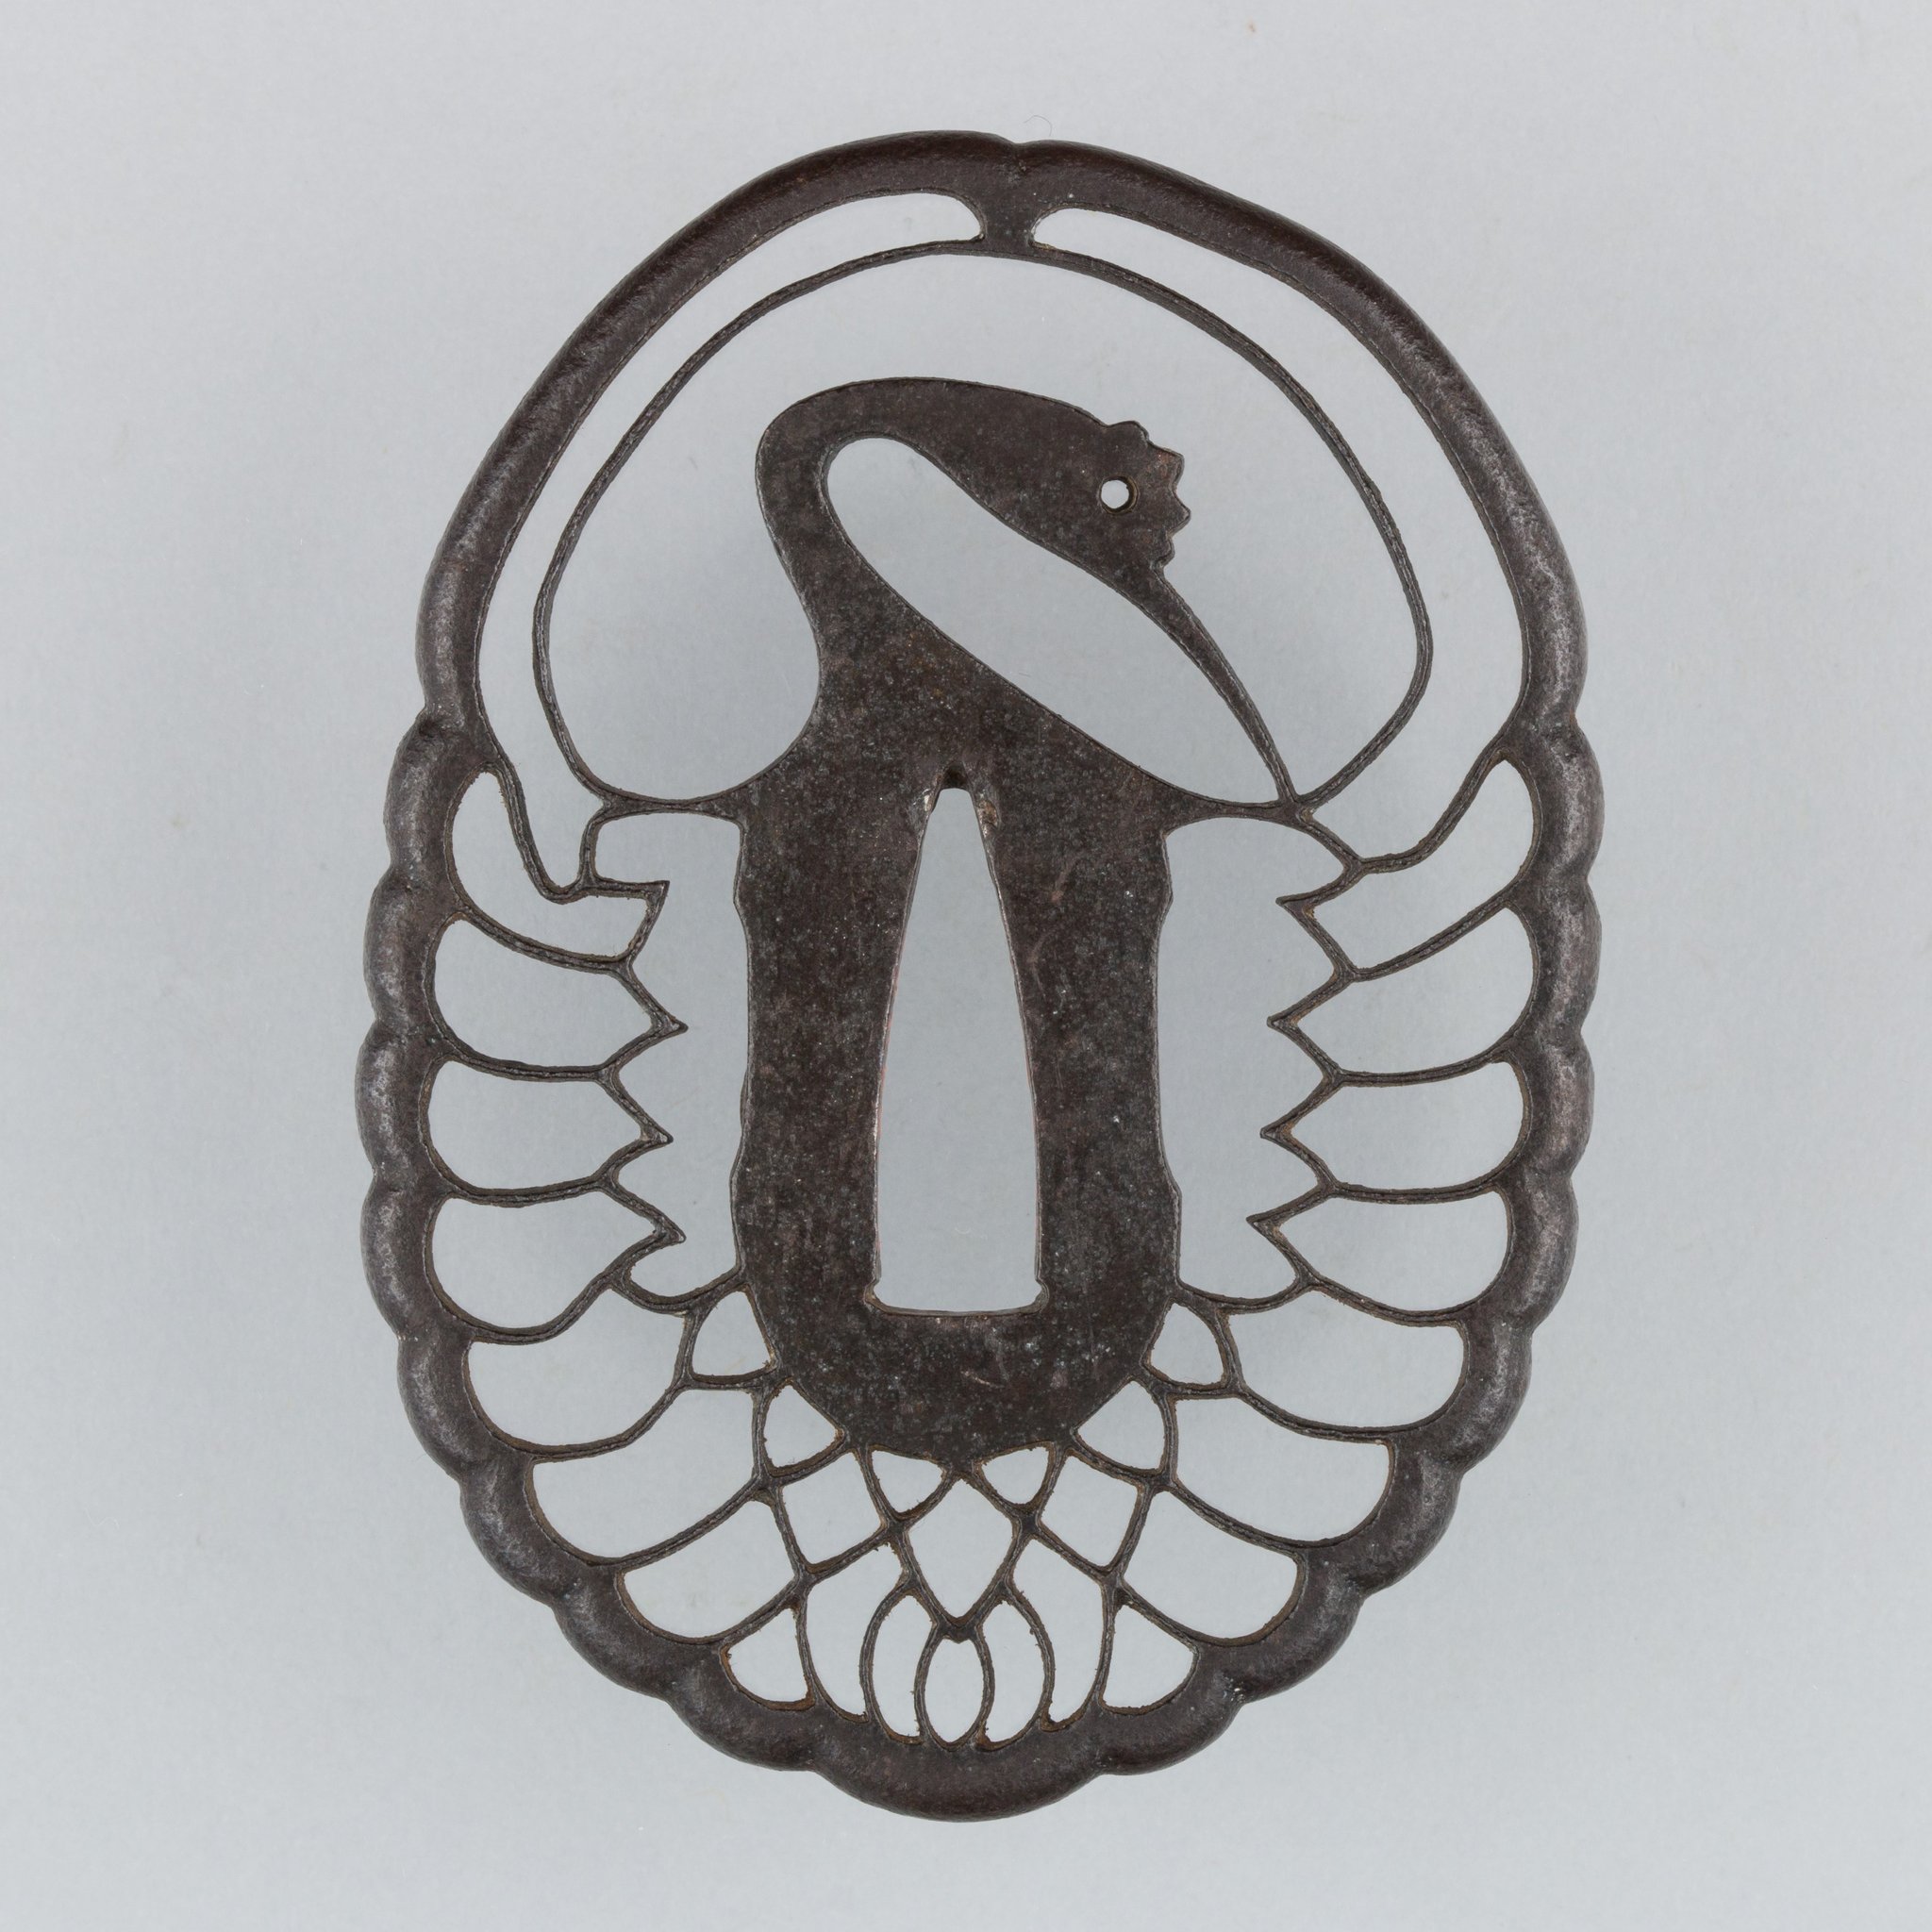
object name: sword guard tsuba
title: Sword Guard (Tsuba)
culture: japanese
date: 1601-1700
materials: copper, iron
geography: japan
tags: birds